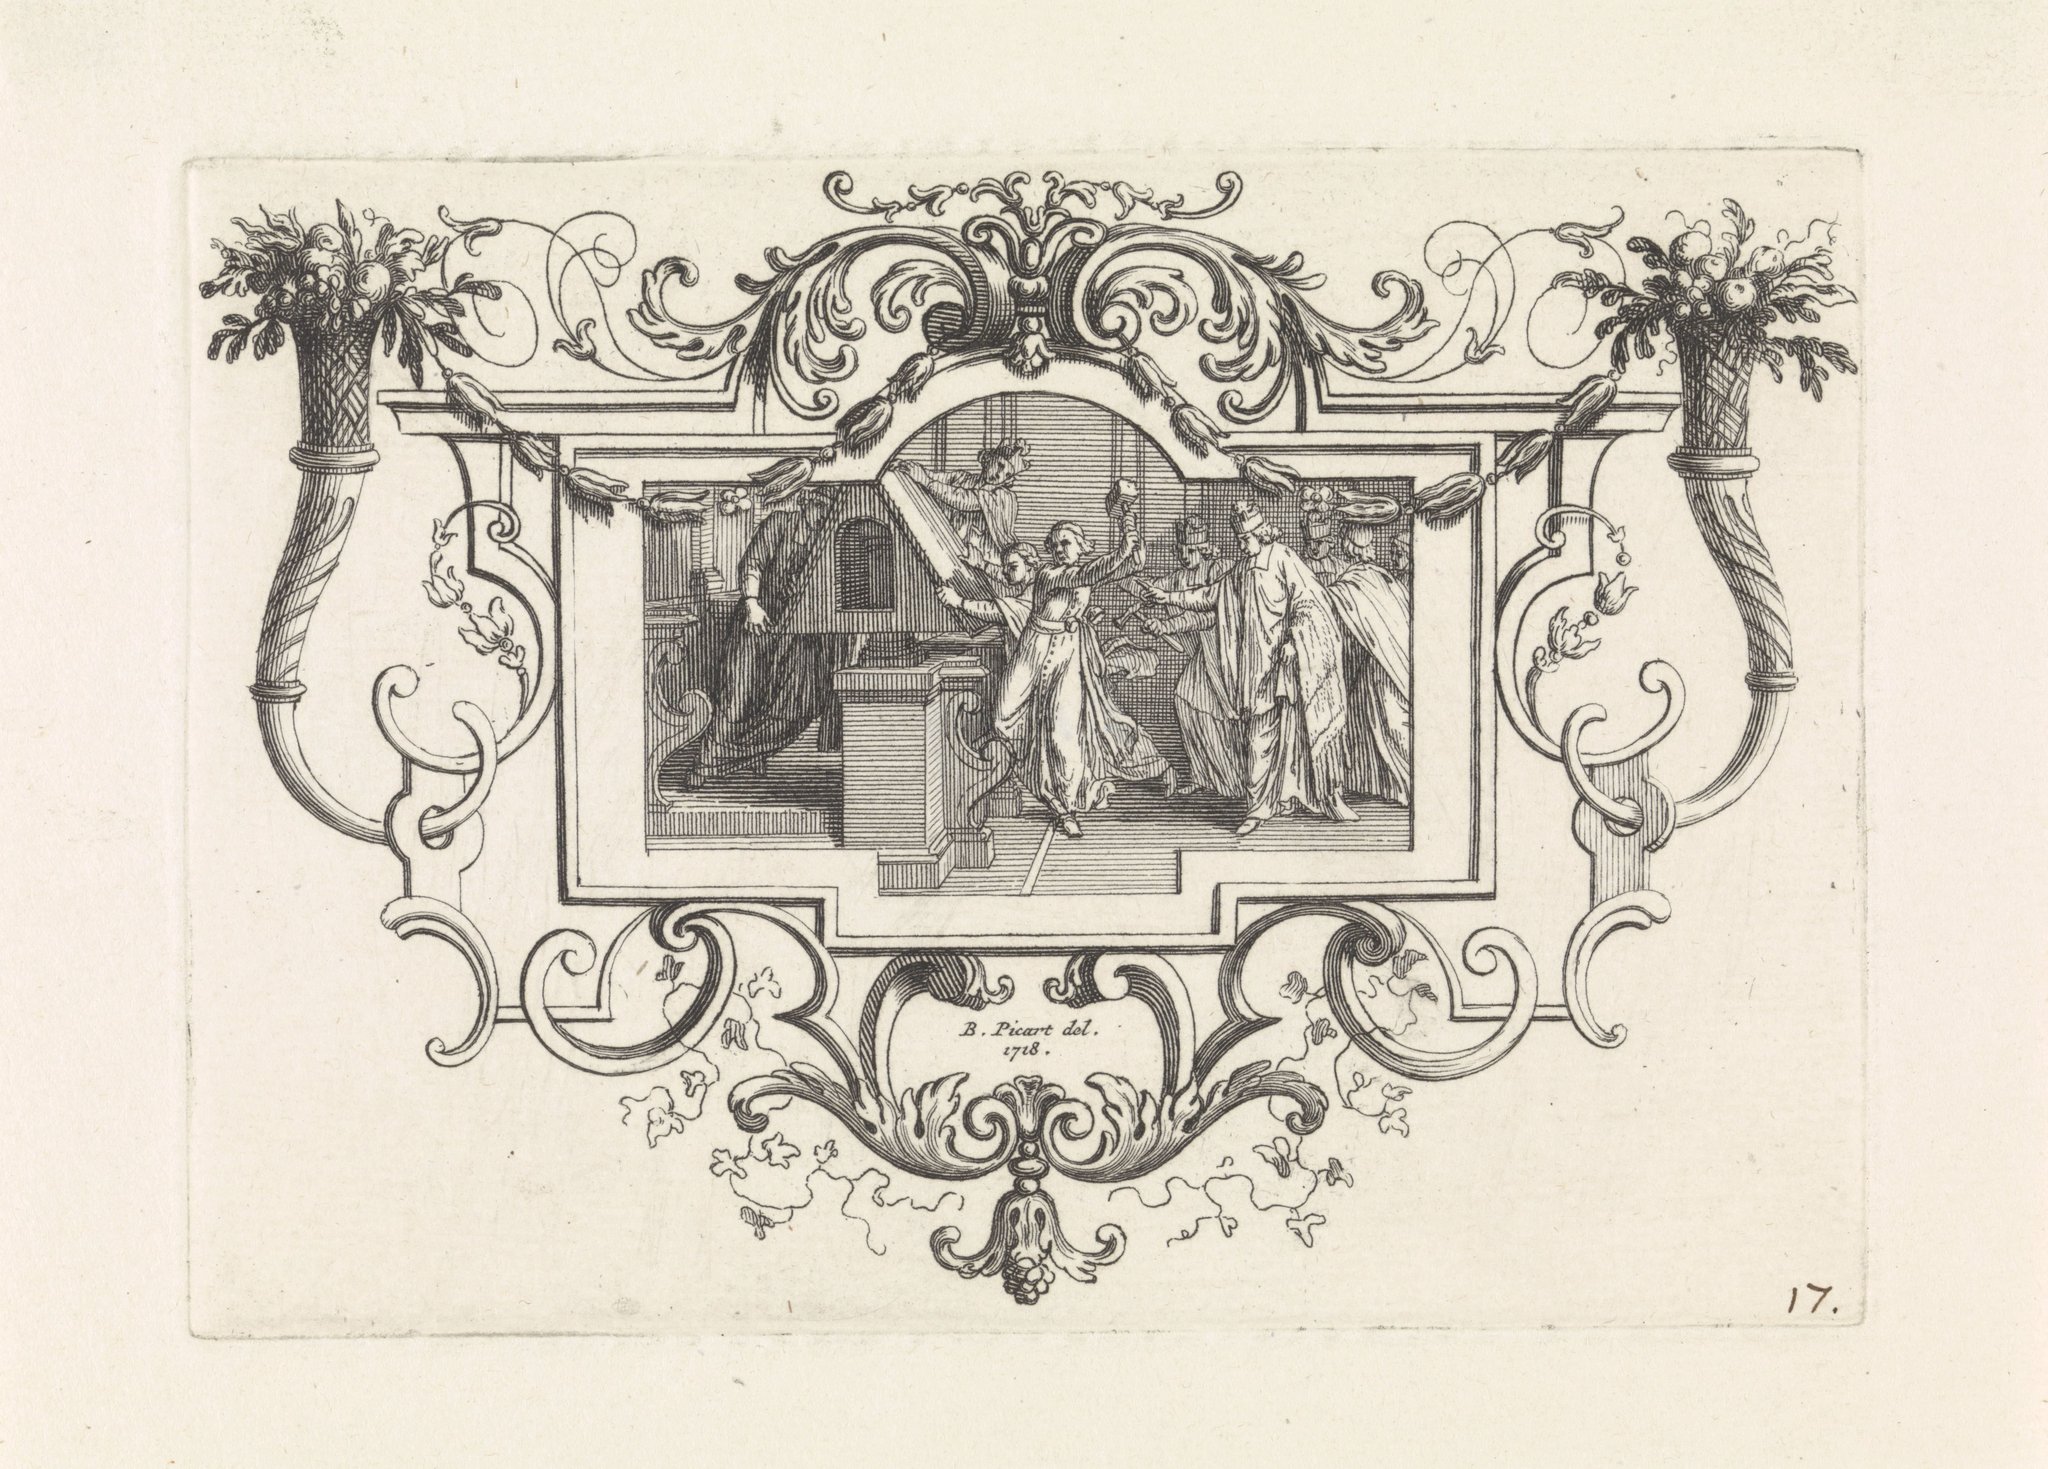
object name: ornament print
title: Geestelijken verwoesten een lessenaar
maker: bernard picart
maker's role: draughtsman, print maker, publisher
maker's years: 1673-1733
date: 1718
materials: paper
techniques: engraving, etching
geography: amsterdam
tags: (liturgical) equipment of church, ornaments ~ art, destruction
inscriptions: number: ‘17.’, collector's mark: Lugt 2233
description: Geestelijken verwoesten met hamers een lessenaar. De voorstelling is gevat in een ornamentele lijst met aan weerszijden hoornen des overvloeds.